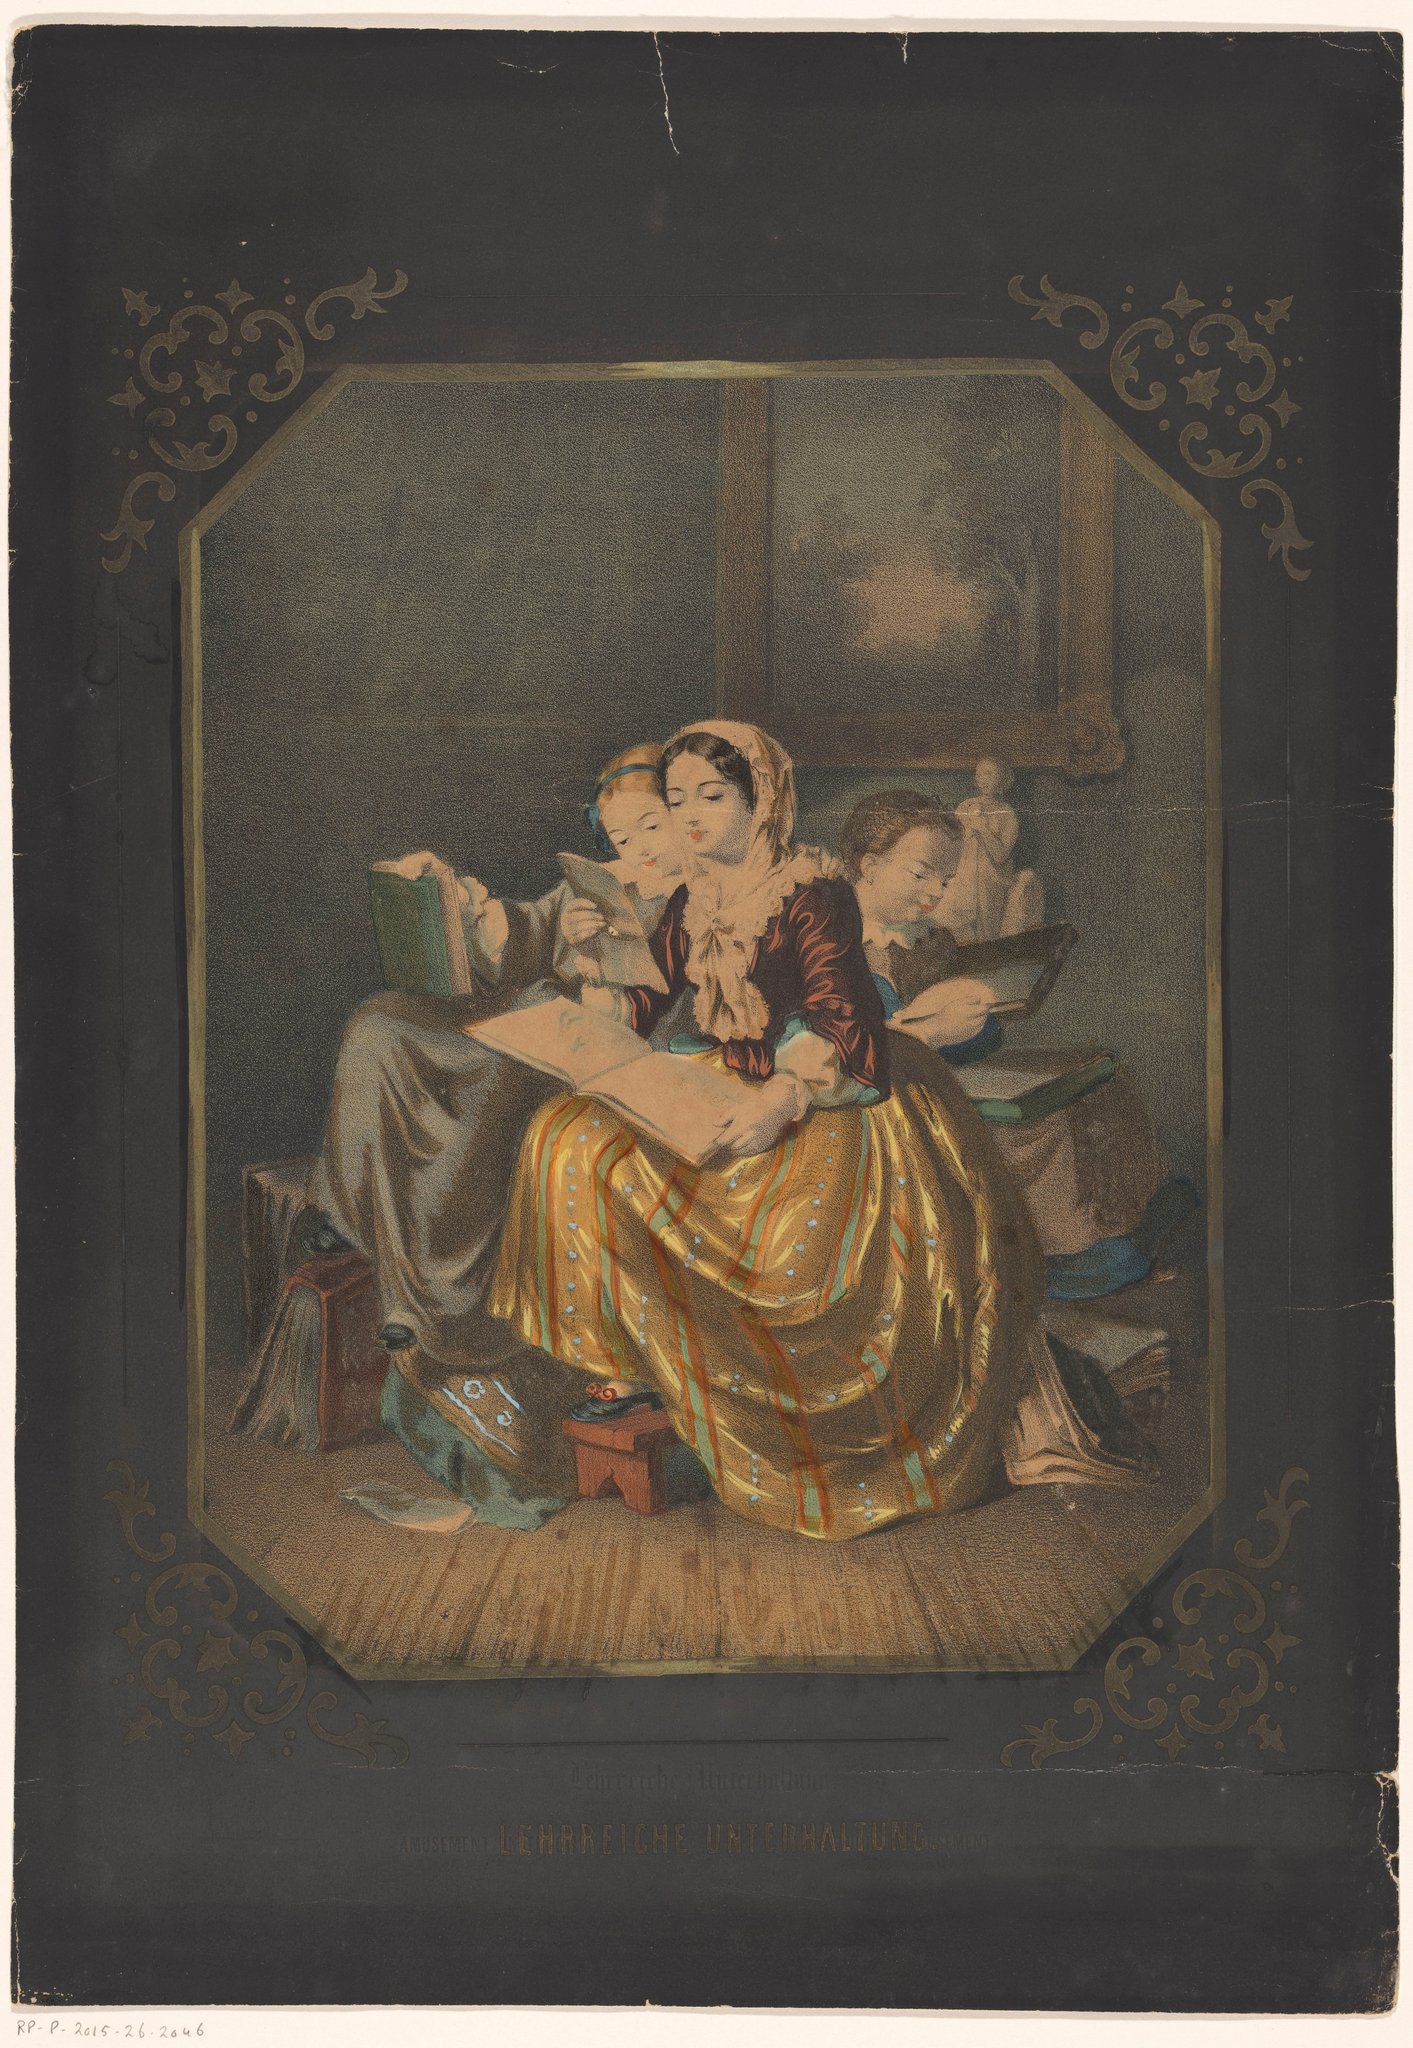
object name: print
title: Lehrreiche Unterhaltung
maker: Anonymous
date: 1850-1900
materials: paper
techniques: hand coloring, lithograph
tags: reading, book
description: Rondom de afbeelding is het blad zwart gemaakt en onder voorzien van een Duitse titel in goud. Oorspronkelijk was de prent getiteld in het Duits, Frans en Engels. Deze titels zijn zichtbaar door de zwarte verf heen.